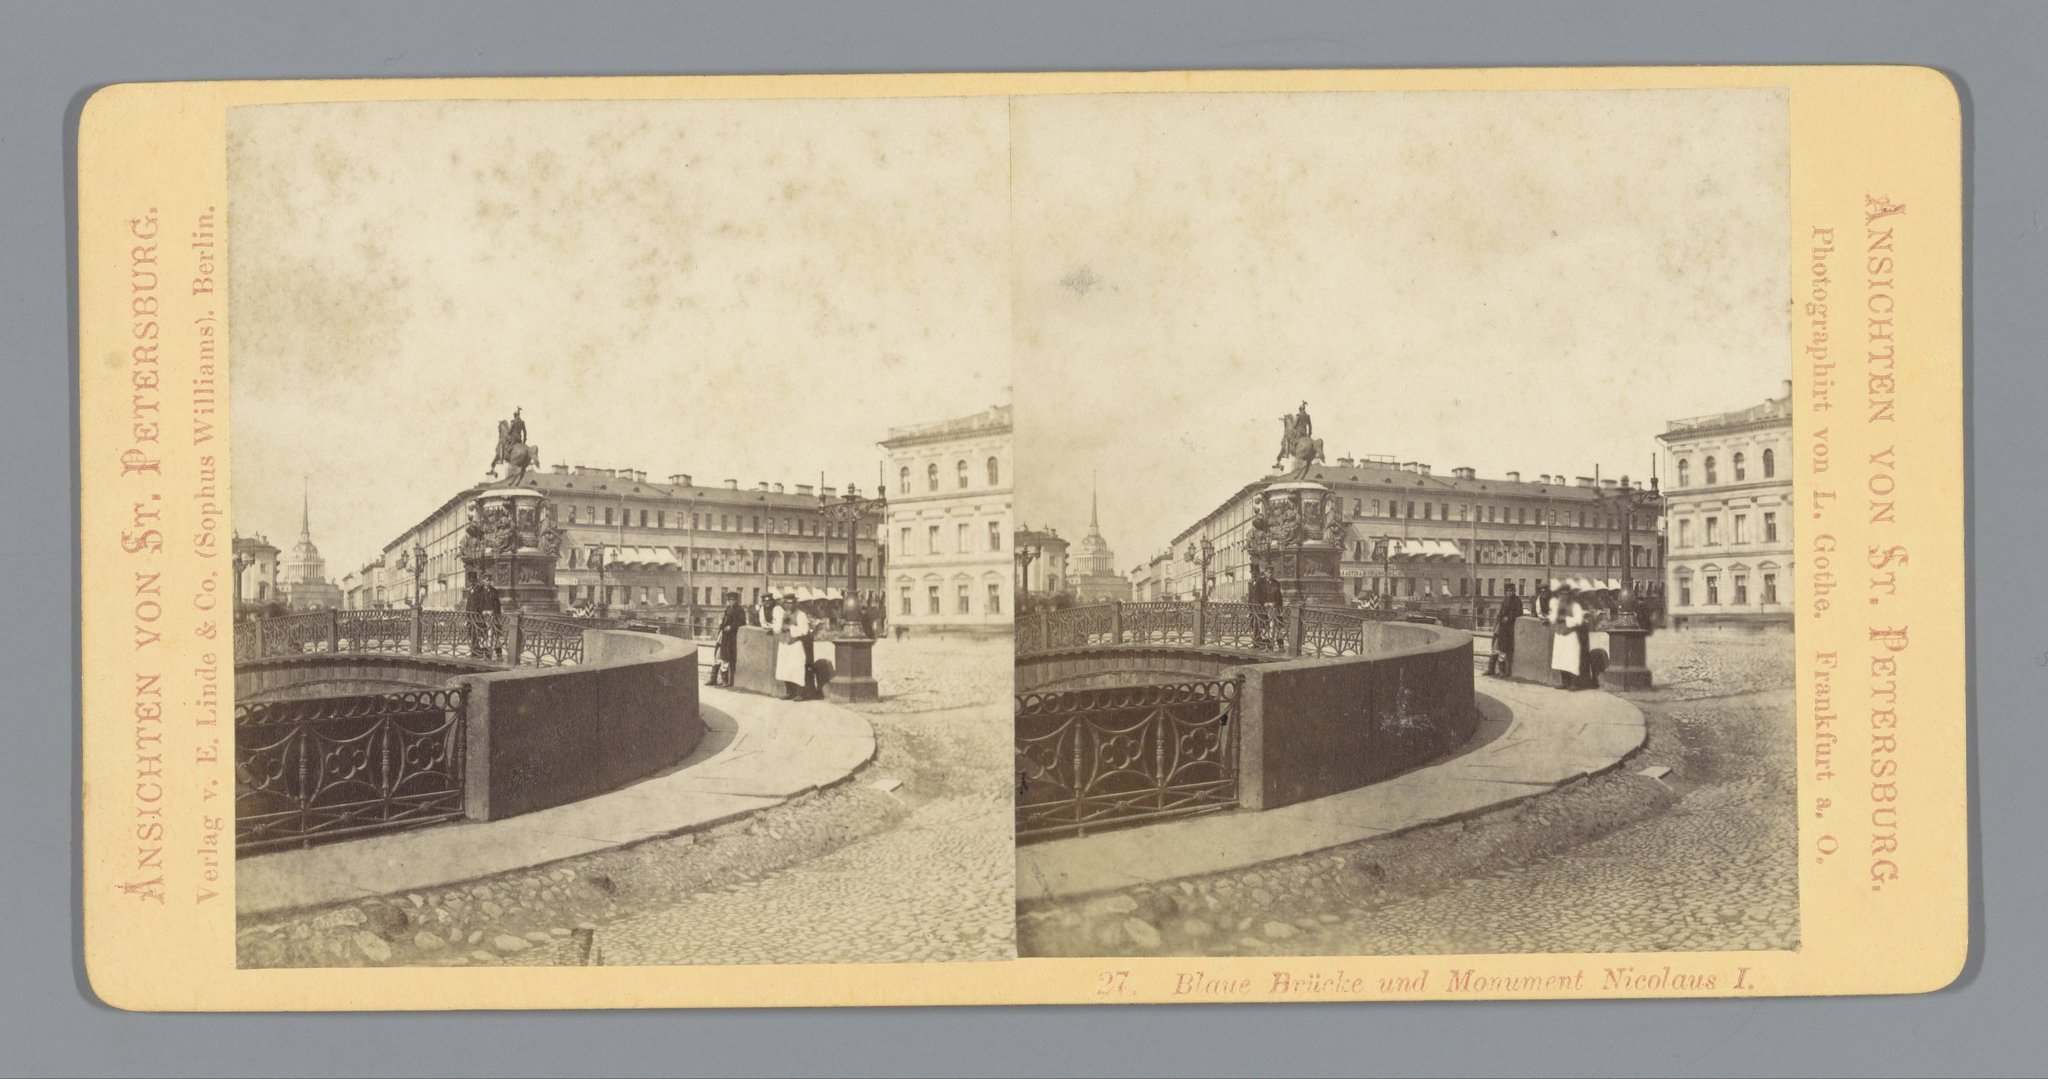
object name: stereograph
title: Gezicht op de Blauwe brug en het ruiterstandbeeld van Nicolaas I van Rusland in Sint-Petersburg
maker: louis gothe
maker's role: fotograaf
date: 1850-1880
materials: cardboard, photographic support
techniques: albumen print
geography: berlin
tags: equestrian statue, bridge in city across river, canal, etc.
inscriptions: number: ‘27.’, inscription: ‘Ansichten von St. Petersburg.’